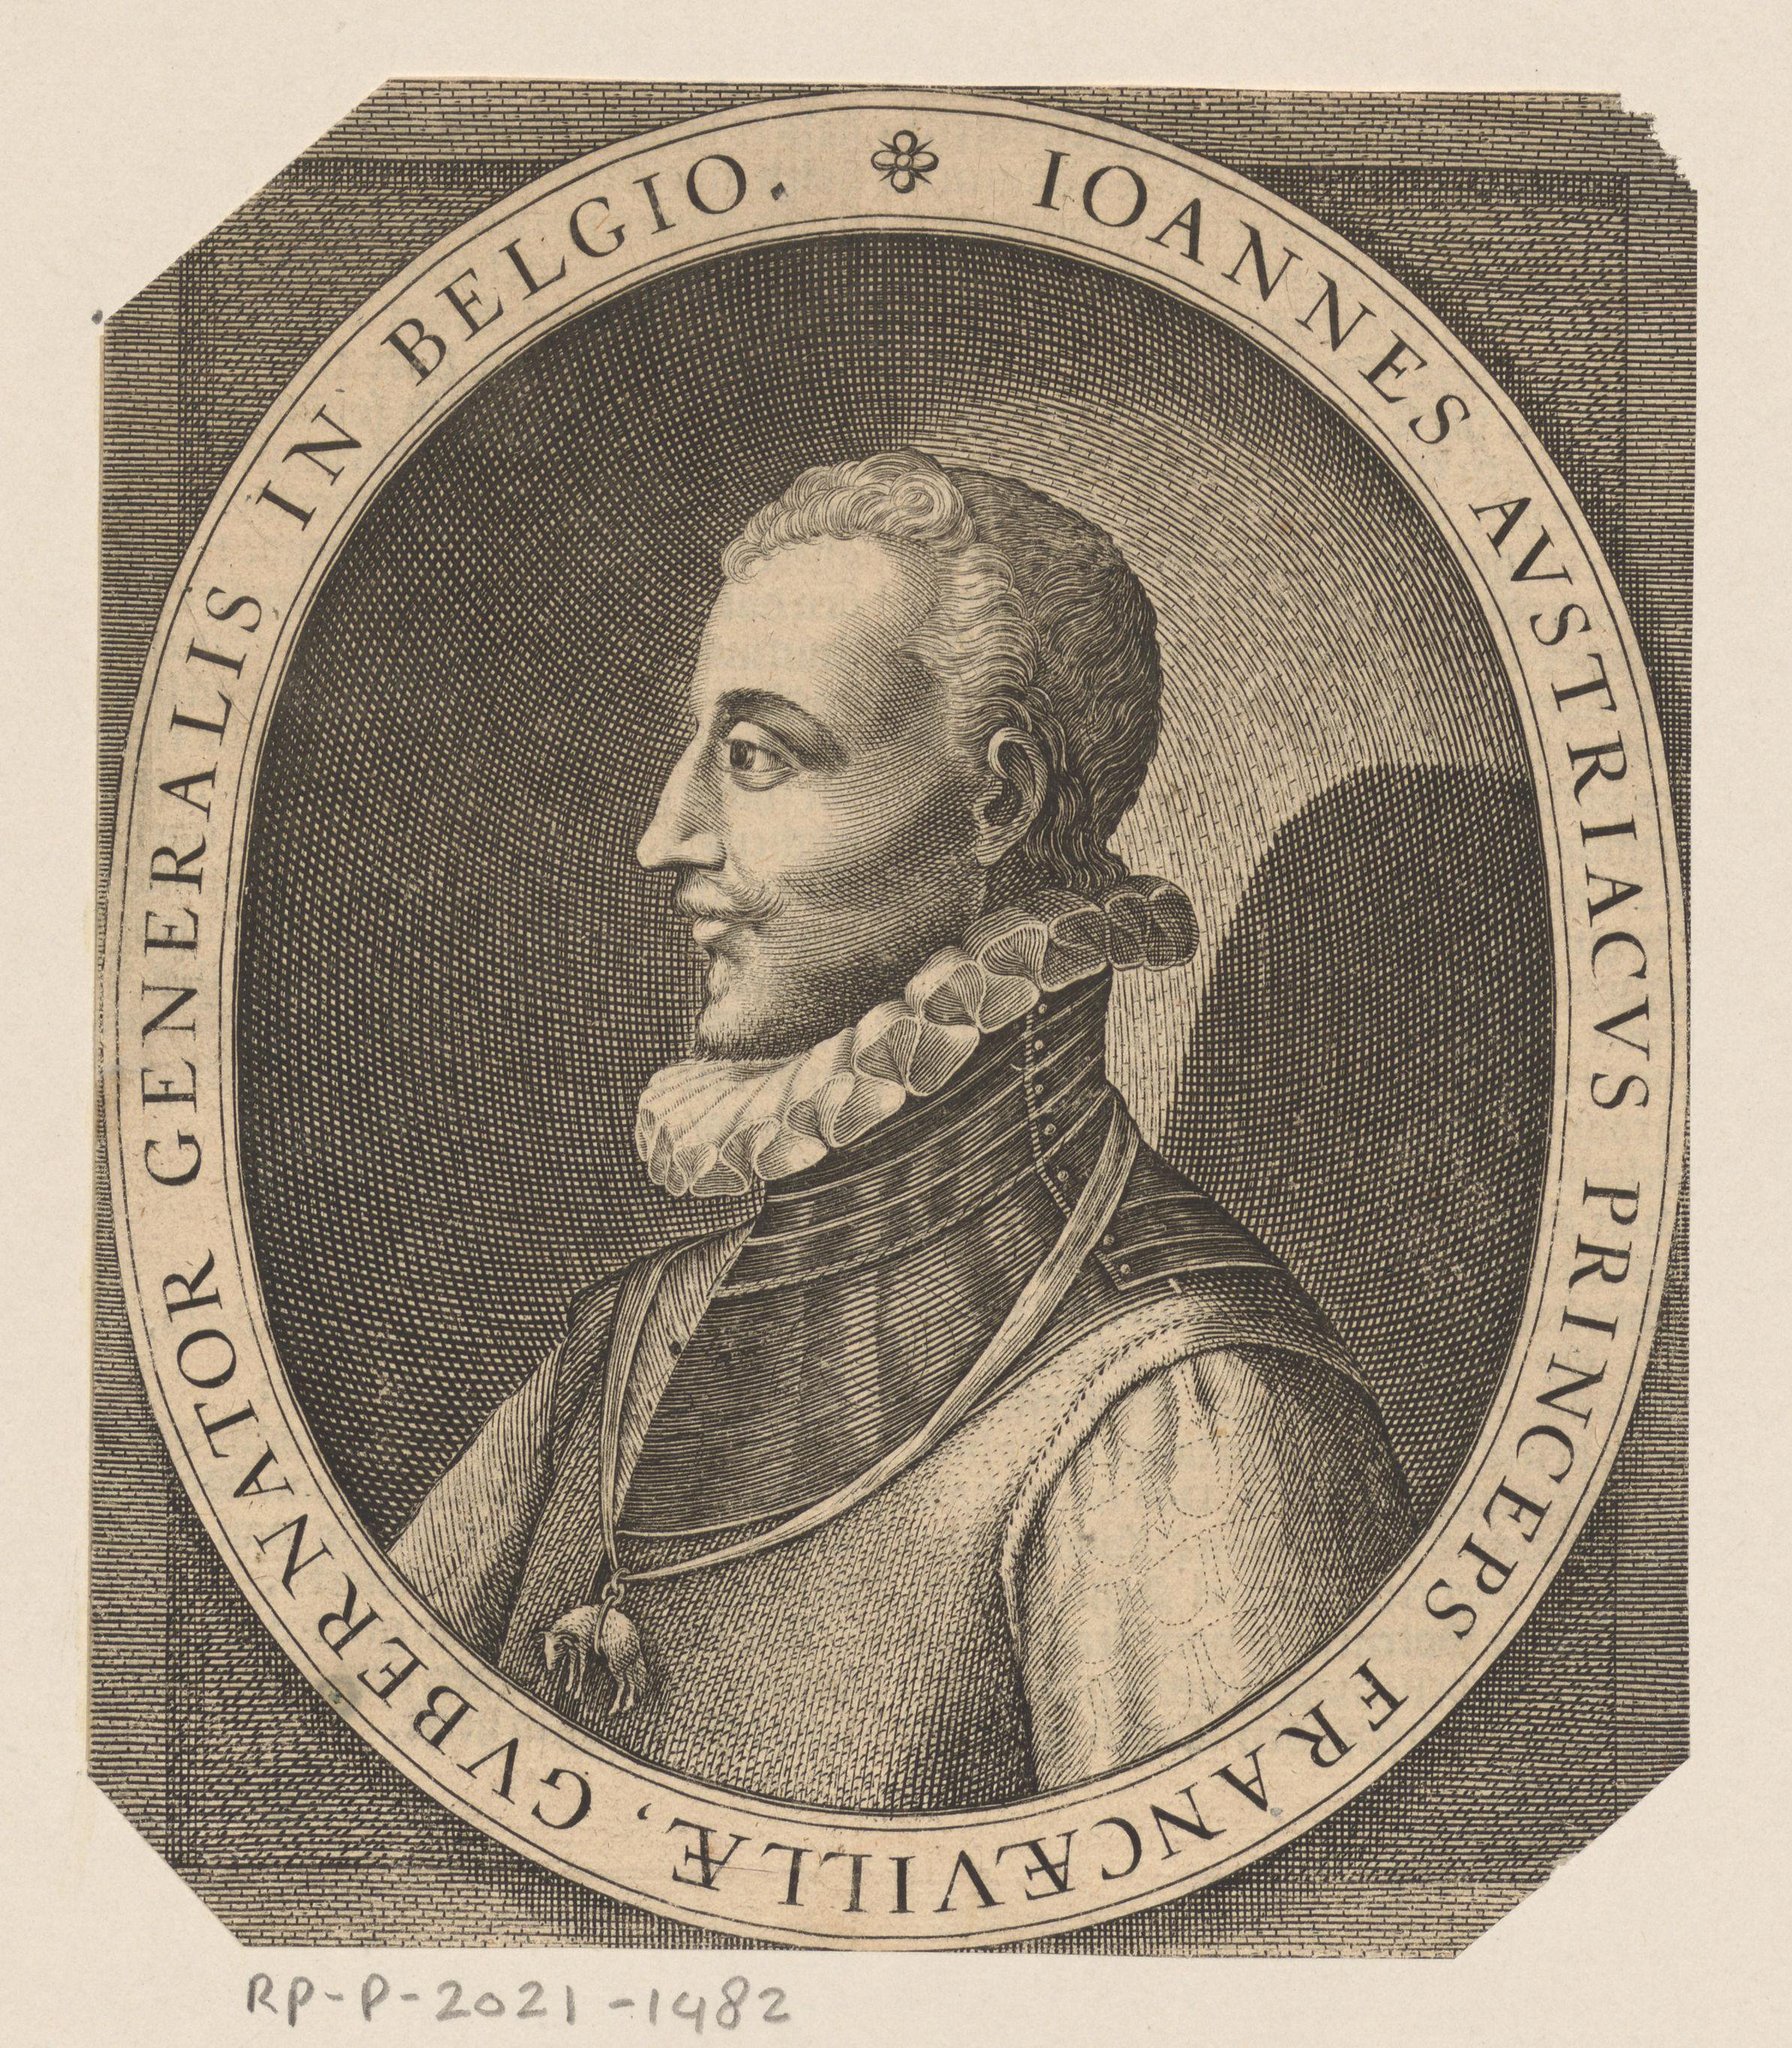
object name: print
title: Portret van Don Juan van Oostenrijk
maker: Anonymous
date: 1616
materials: paper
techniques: engraving, letterpress printing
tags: don juan van oostenrijk, historical persons, knighthood order of the golden fleece, ruler, sovereign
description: Prent met andere tekst op verso gebruikt in: Baudart, Guillaume. Les guerres de Nassau (...). Amsterdam: Michel Colin, 1616.